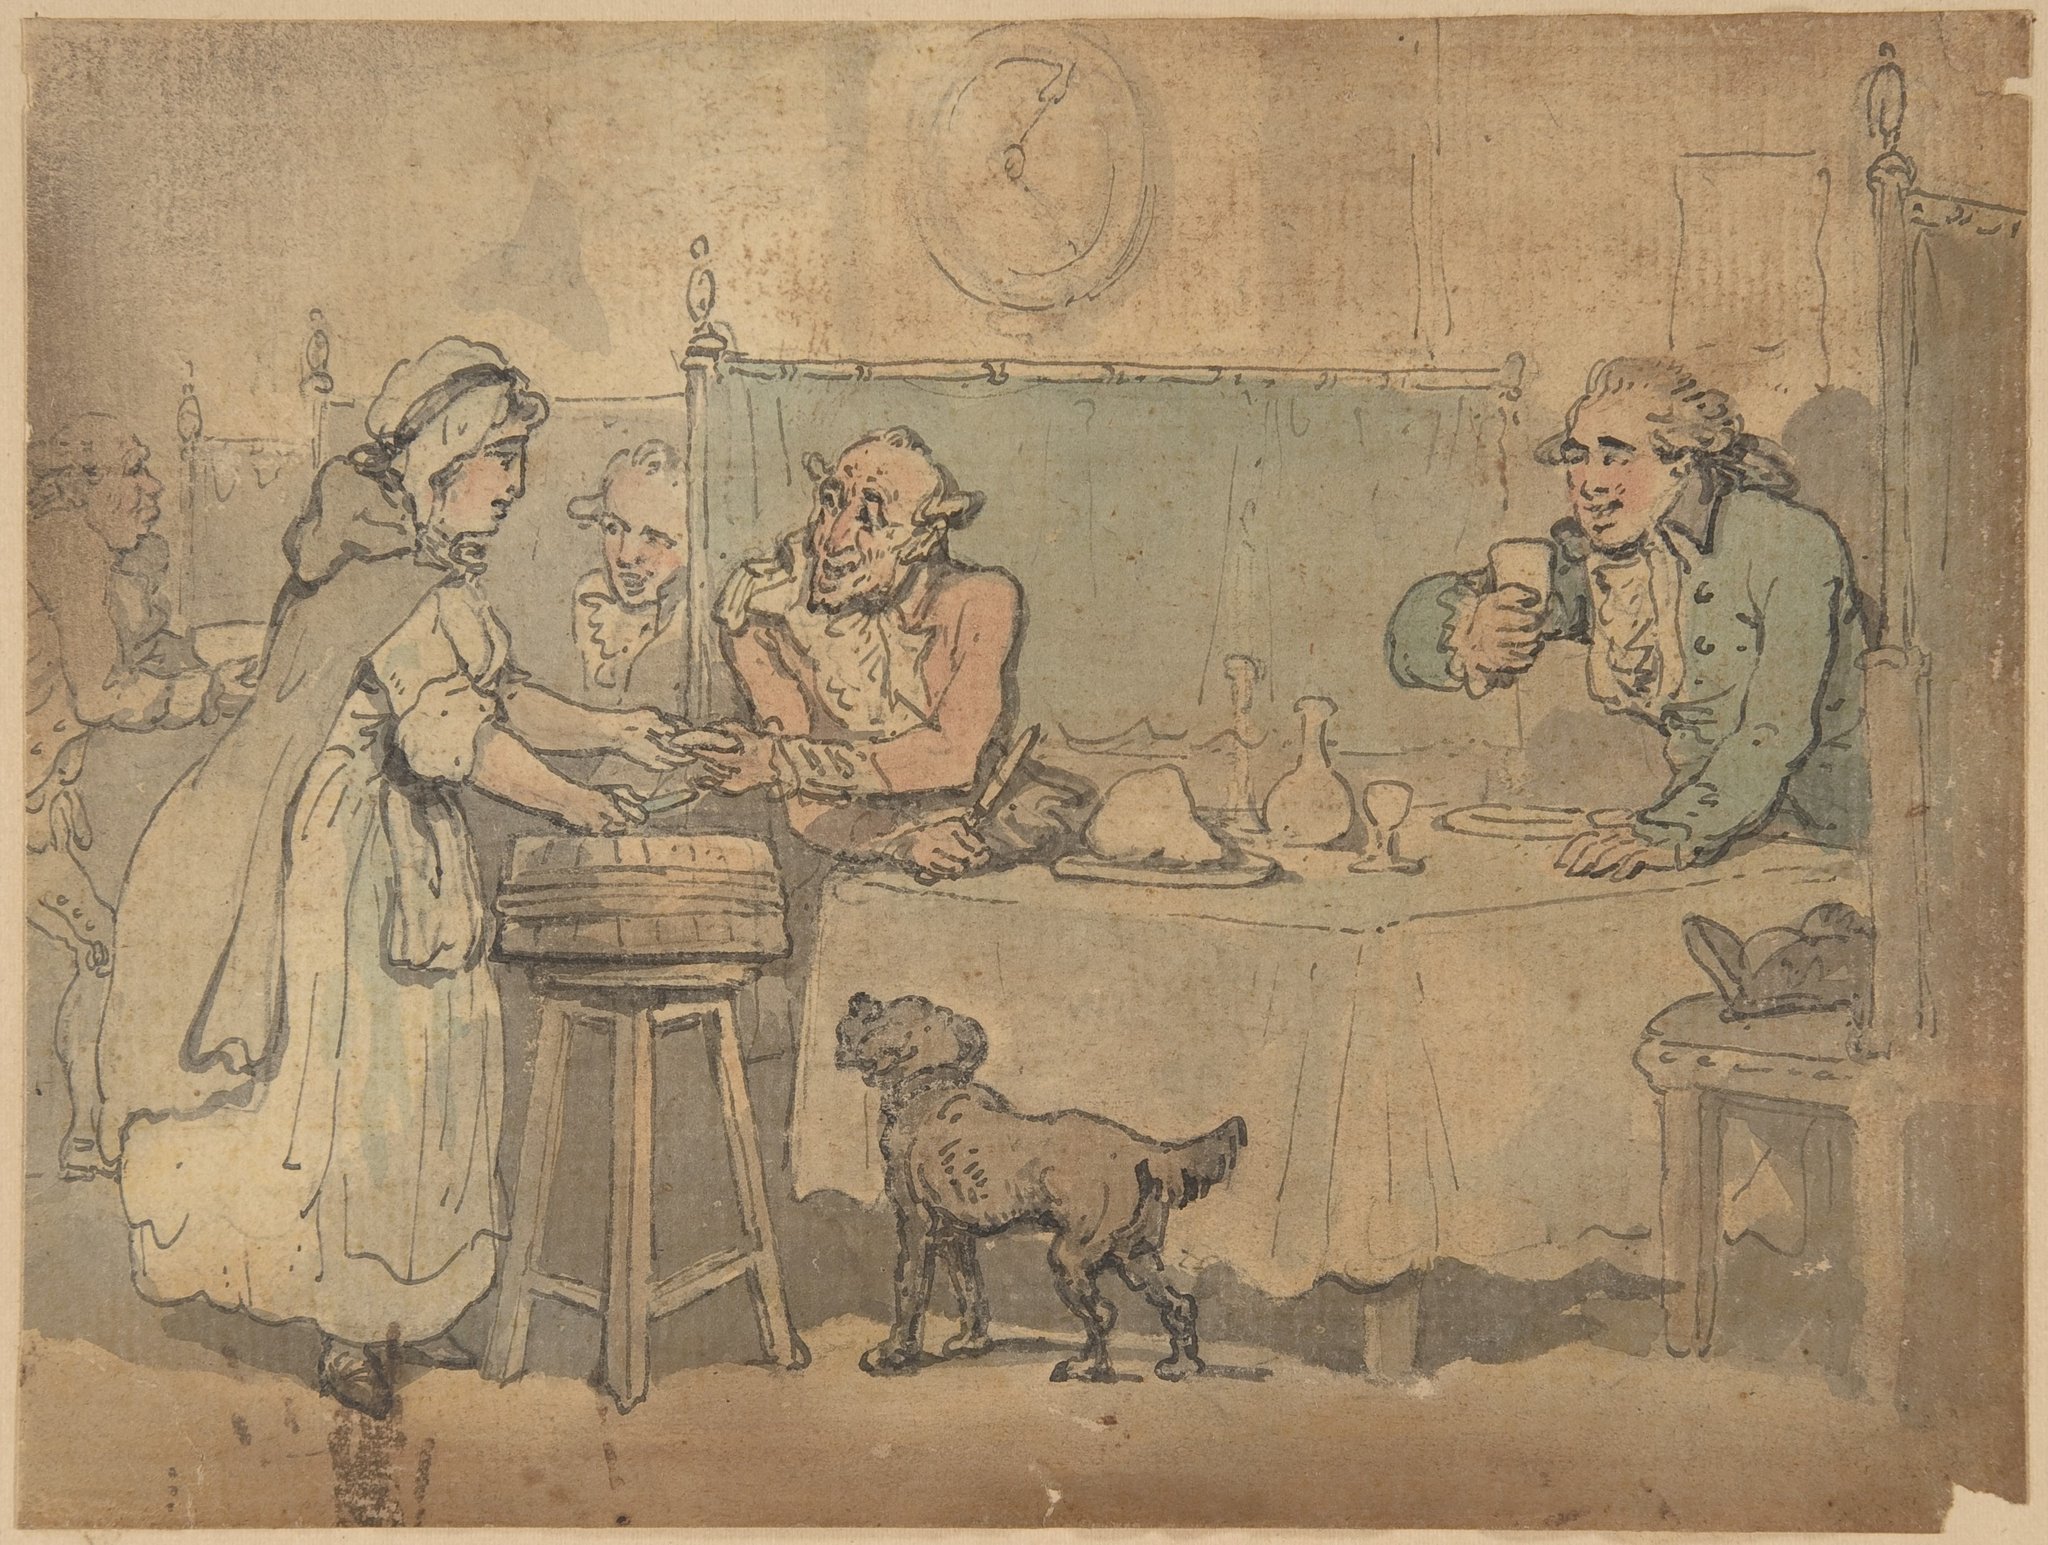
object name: drawing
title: Tavern scene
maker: thomas rowlandson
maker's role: artist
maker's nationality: british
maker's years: 1757-1827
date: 1780-1827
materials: graphite, ink, watercolor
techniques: pen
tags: taverns,men,women,dogs,drinking